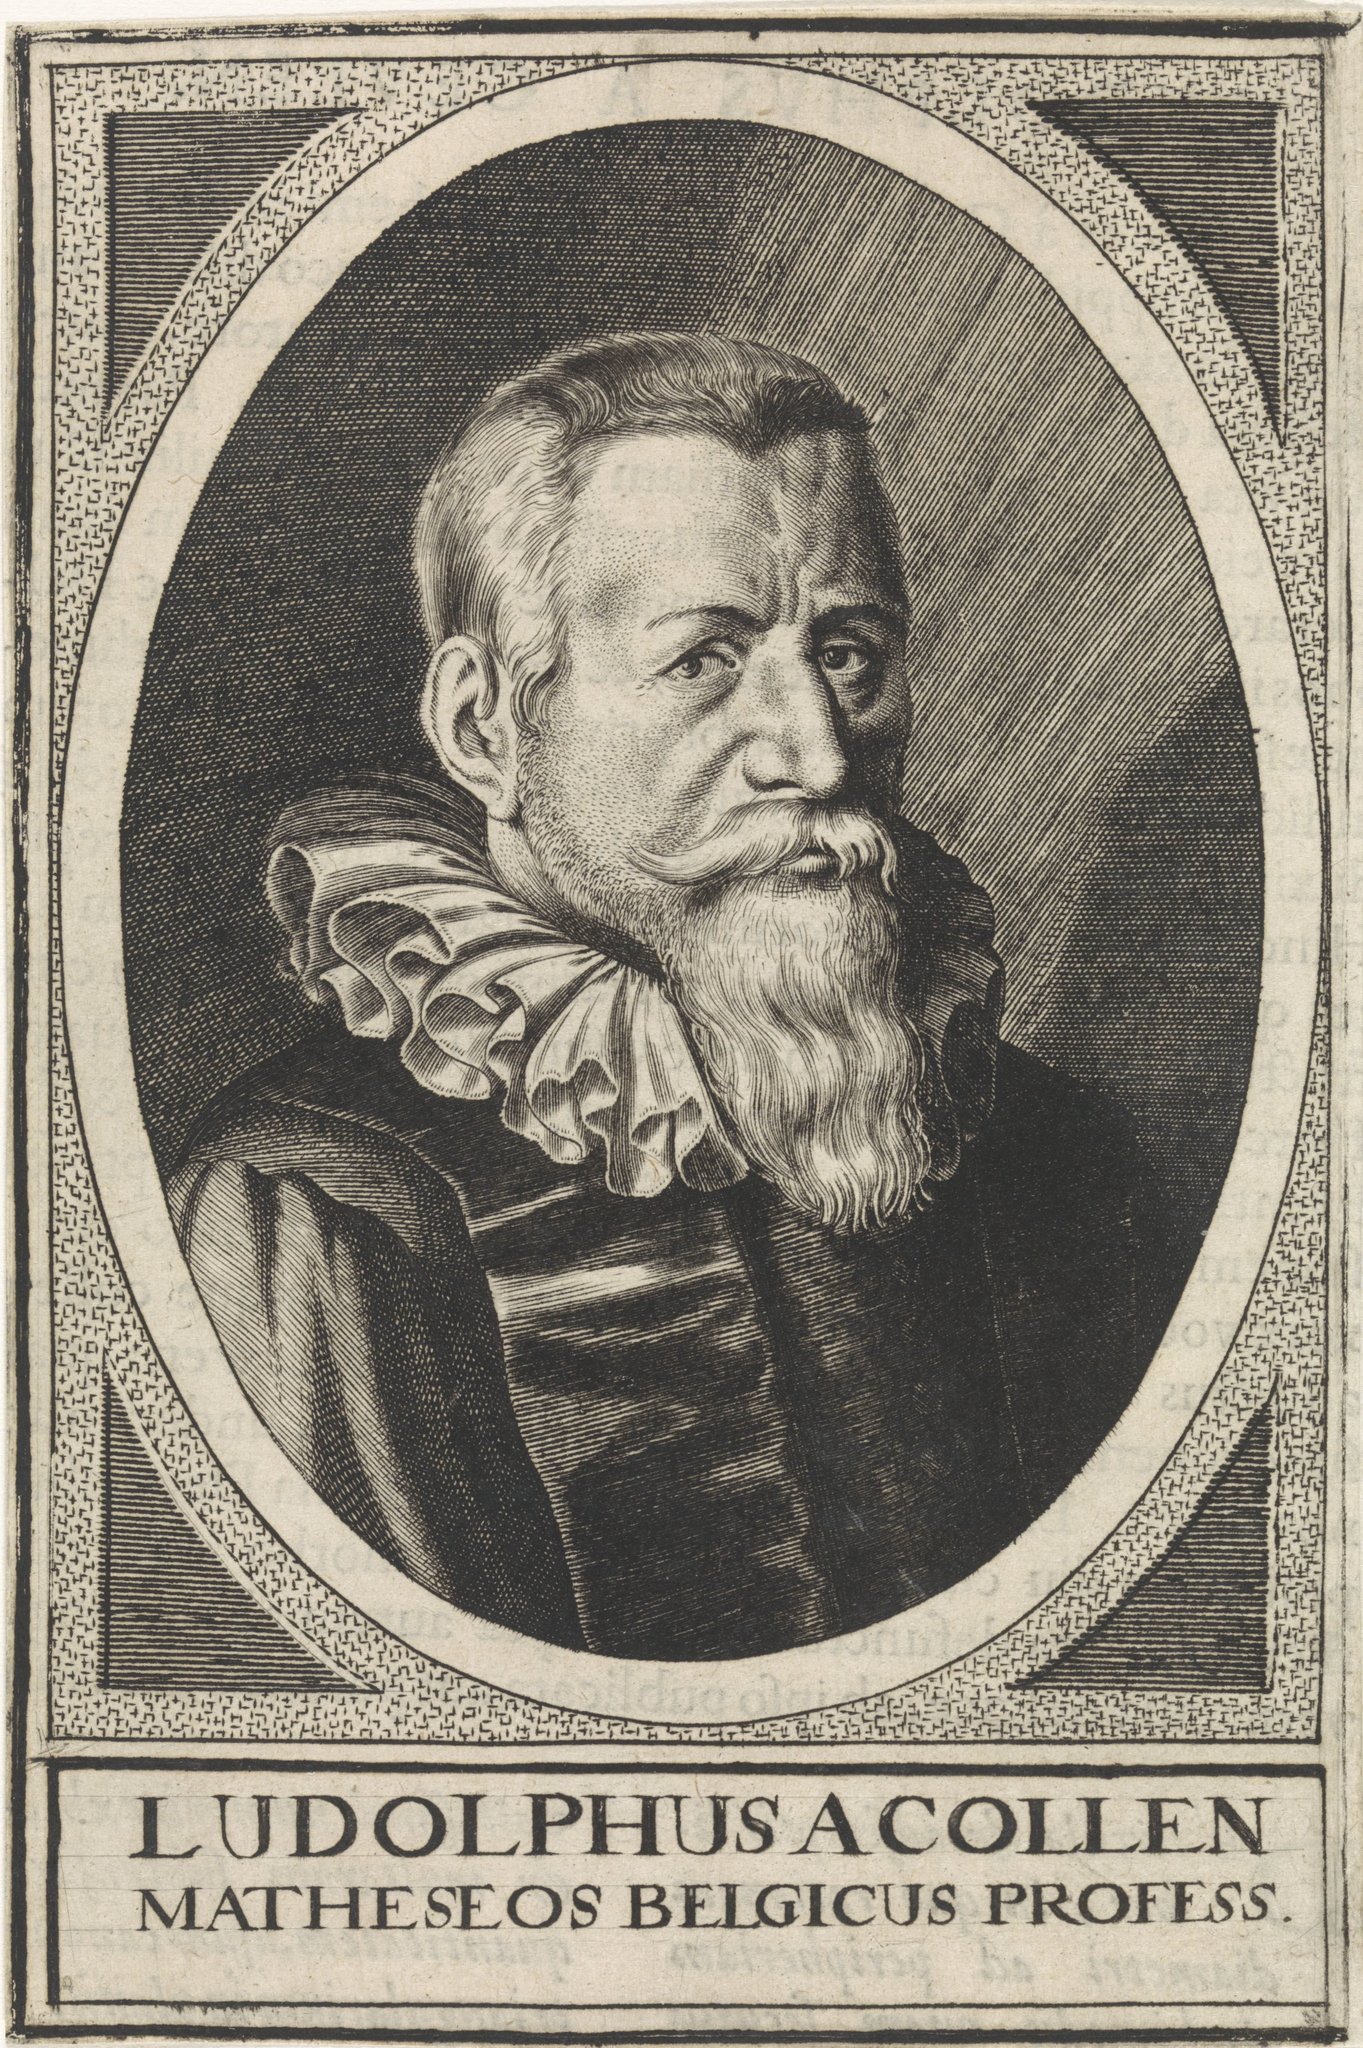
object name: print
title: Portret van Ludolph van Ceulen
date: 1625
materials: paper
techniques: engraving, letterpress printing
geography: leiden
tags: leiden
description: Boekillustratie in: Meursius, Joannes. Athenæ Batavæ. Sive, De vrbe Leidensi, & academiâ, virisque claris. Leiden: Andries Clouck, Bonaventura en Abraham Elzevier, 1625. Abusievelijk tweemaal gecatalogiseerd bij Franken & Van der Kellen.